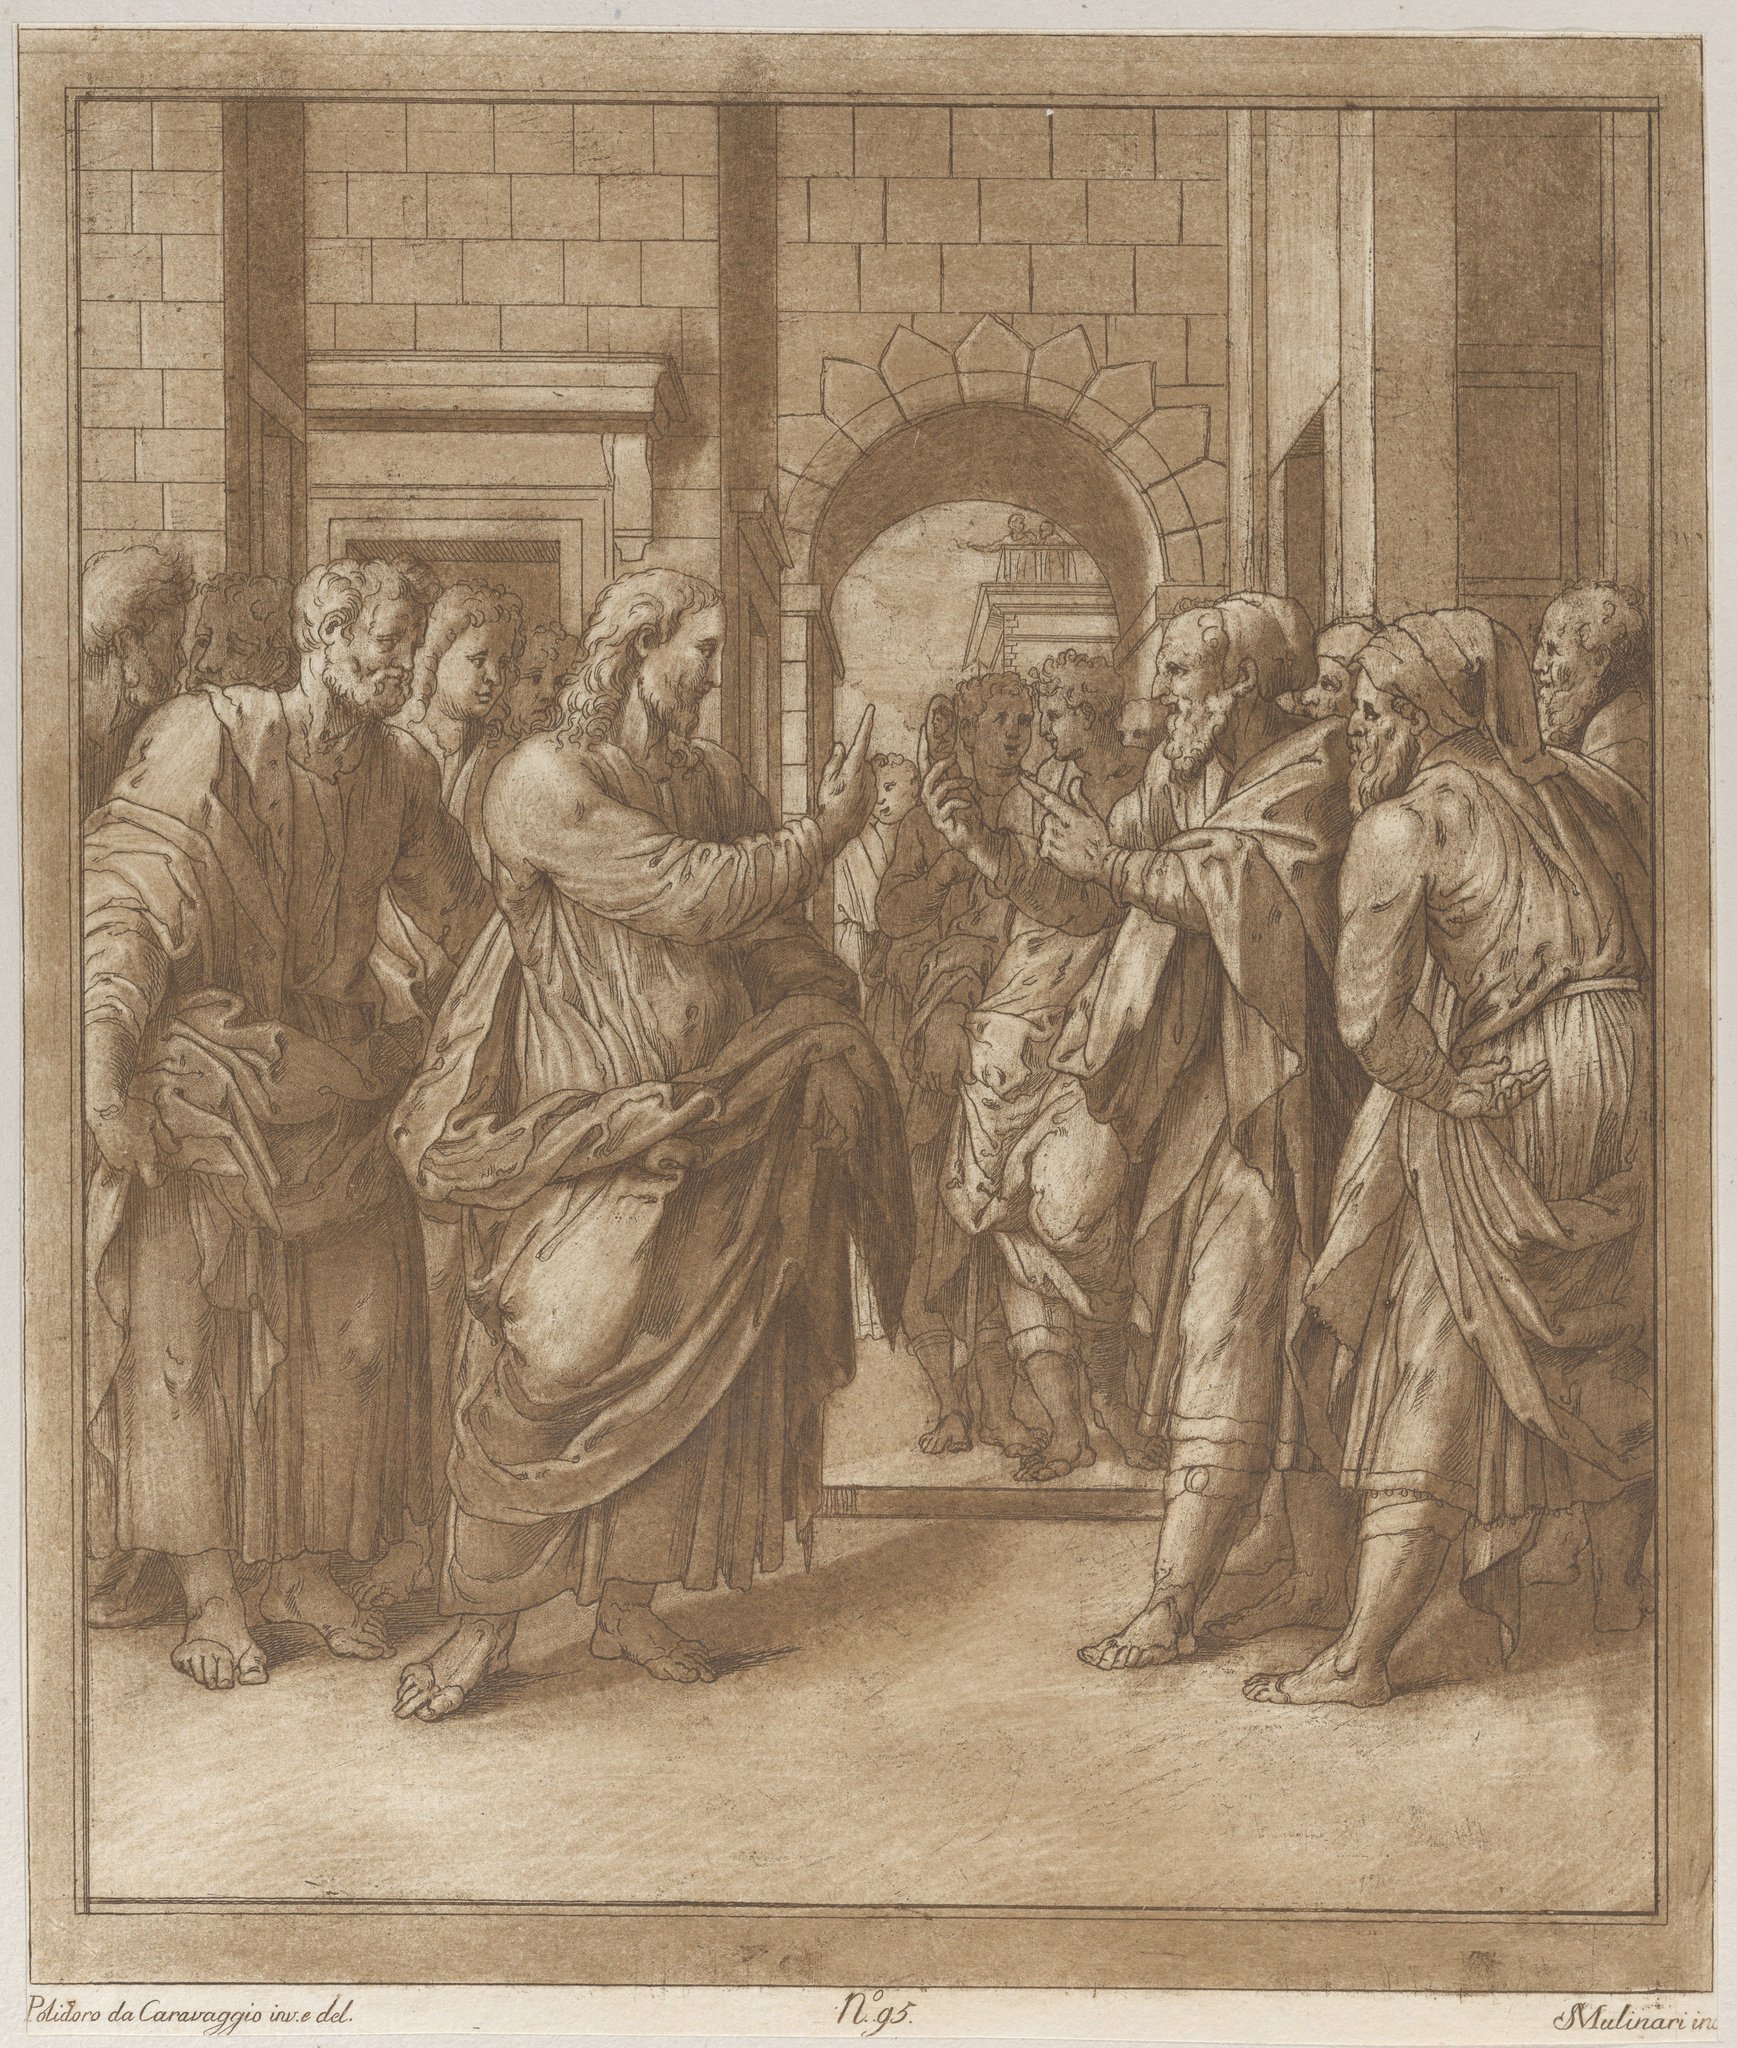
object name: print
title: Christ standing before an entrance to a city surrounded by apostles addressing a group of men at right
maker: stefano mulinari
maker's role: artist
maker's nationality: italian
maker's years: 1736-1795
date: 1761-1790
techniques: etching, printing